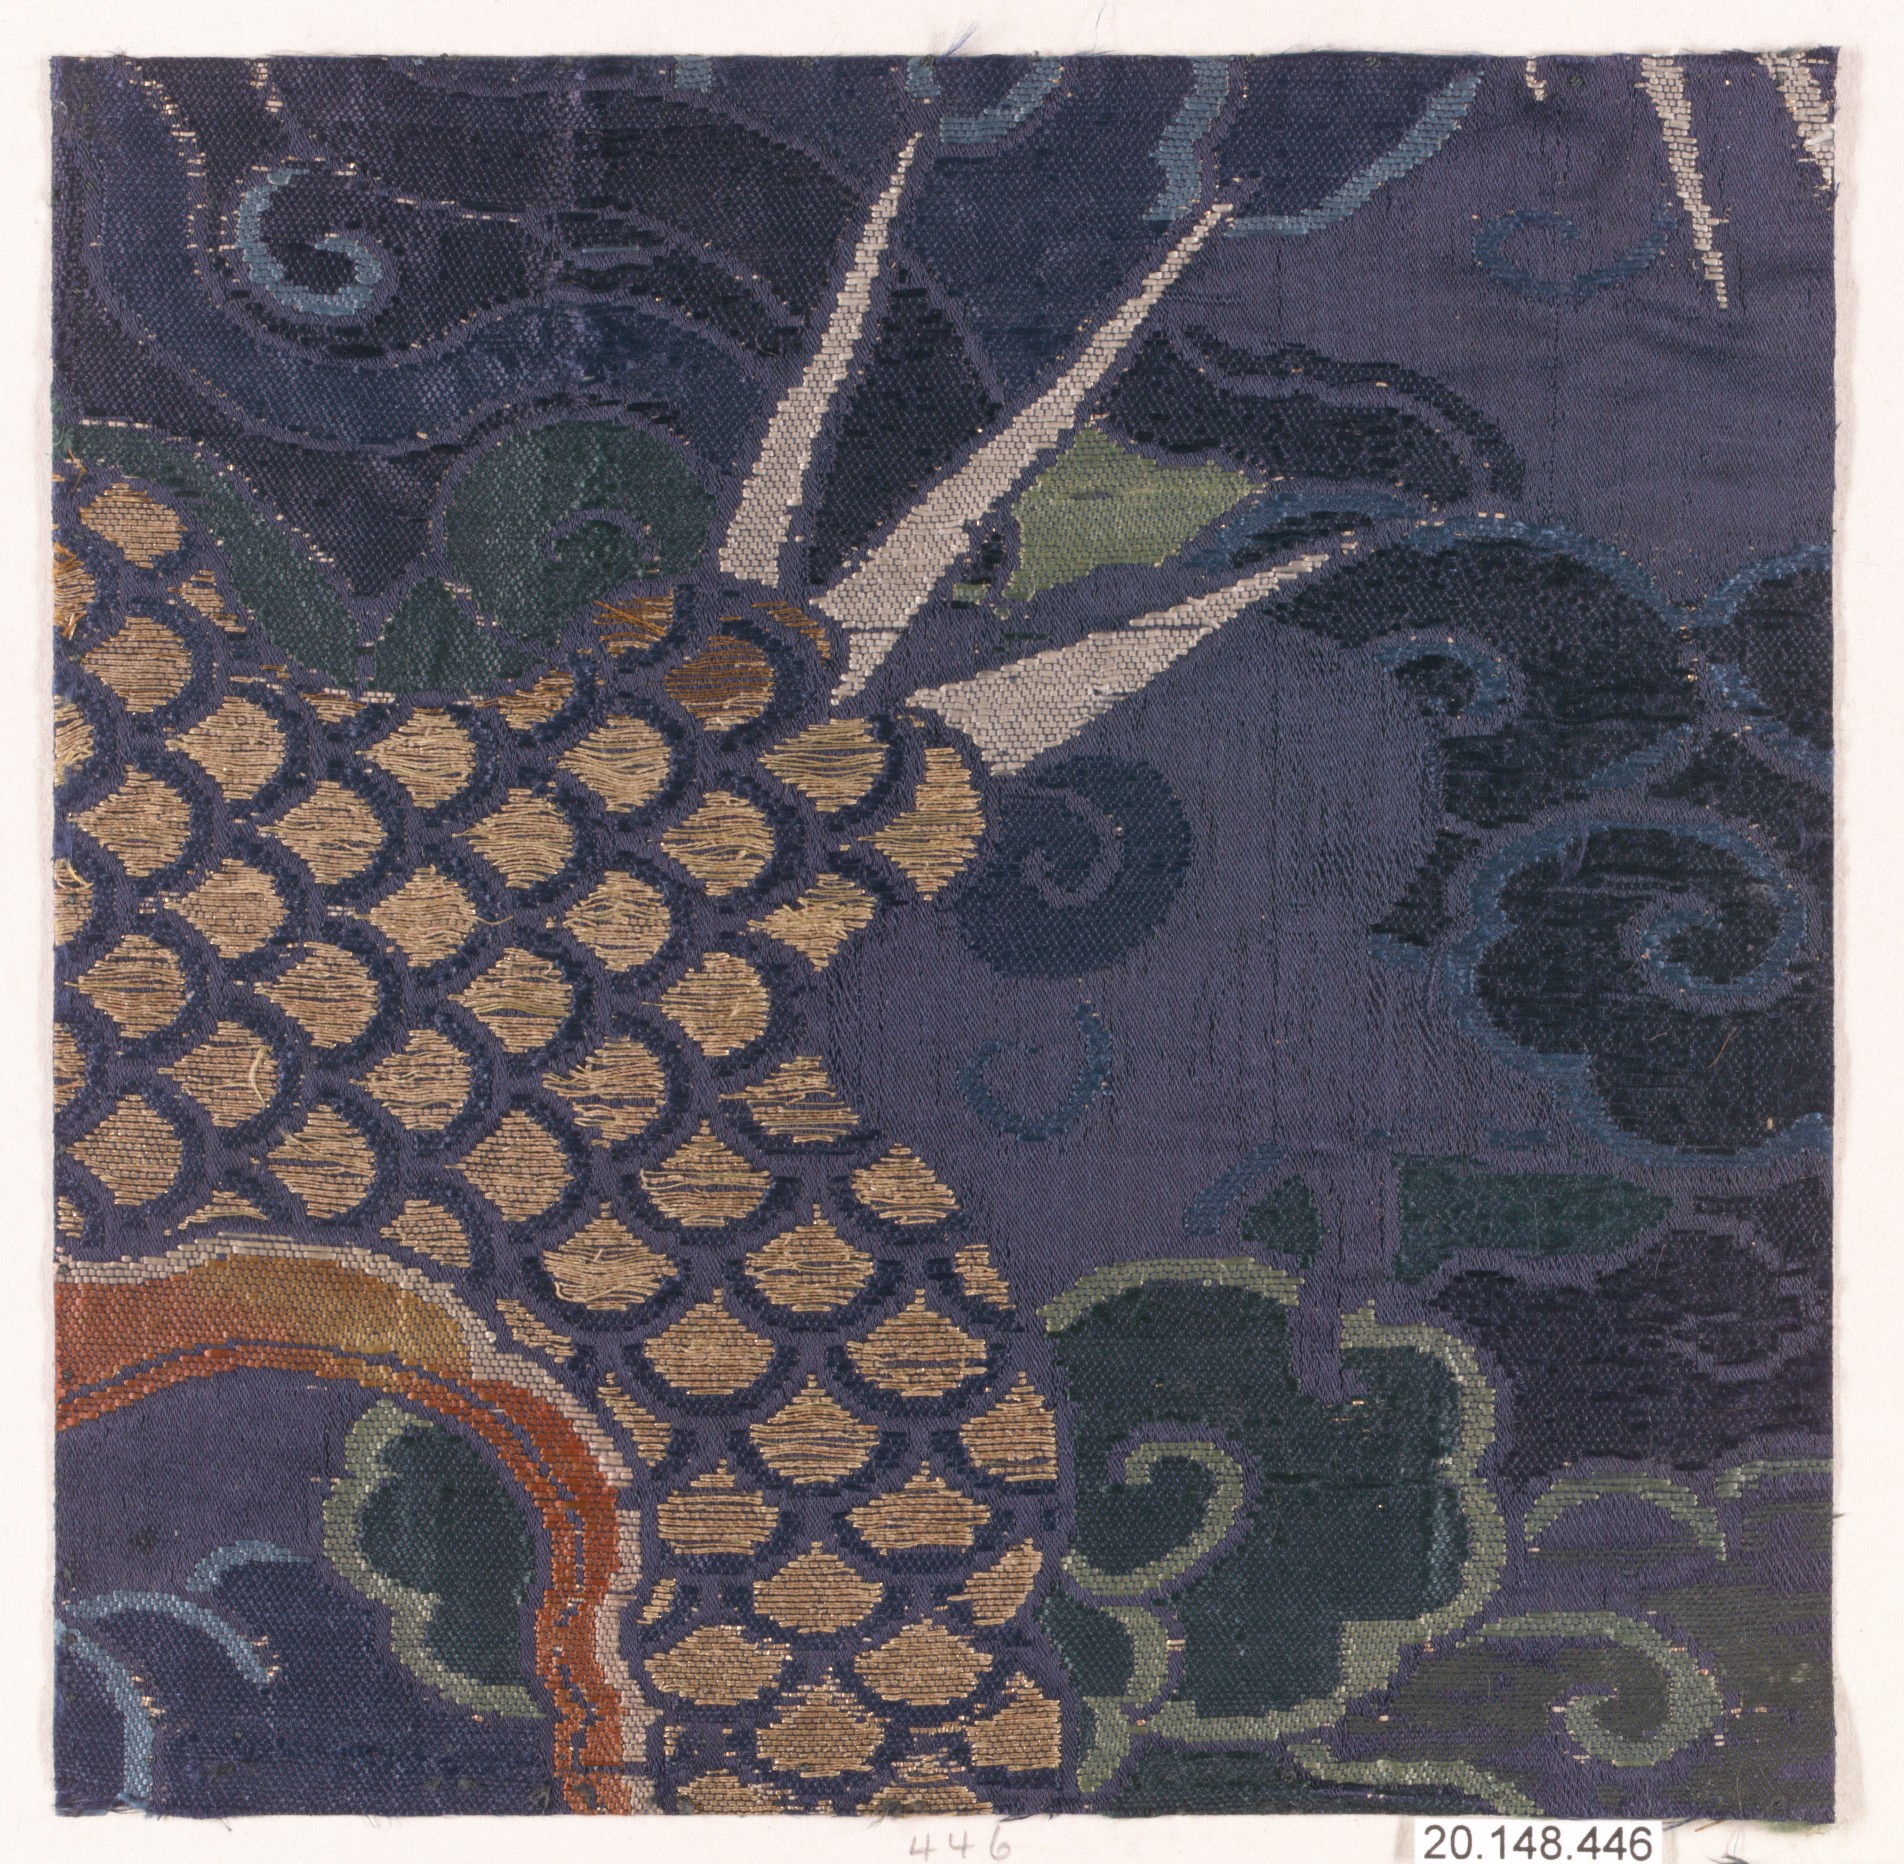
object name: piece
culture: chinese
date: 1601-1700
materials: silk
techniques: compound weave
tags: dragons